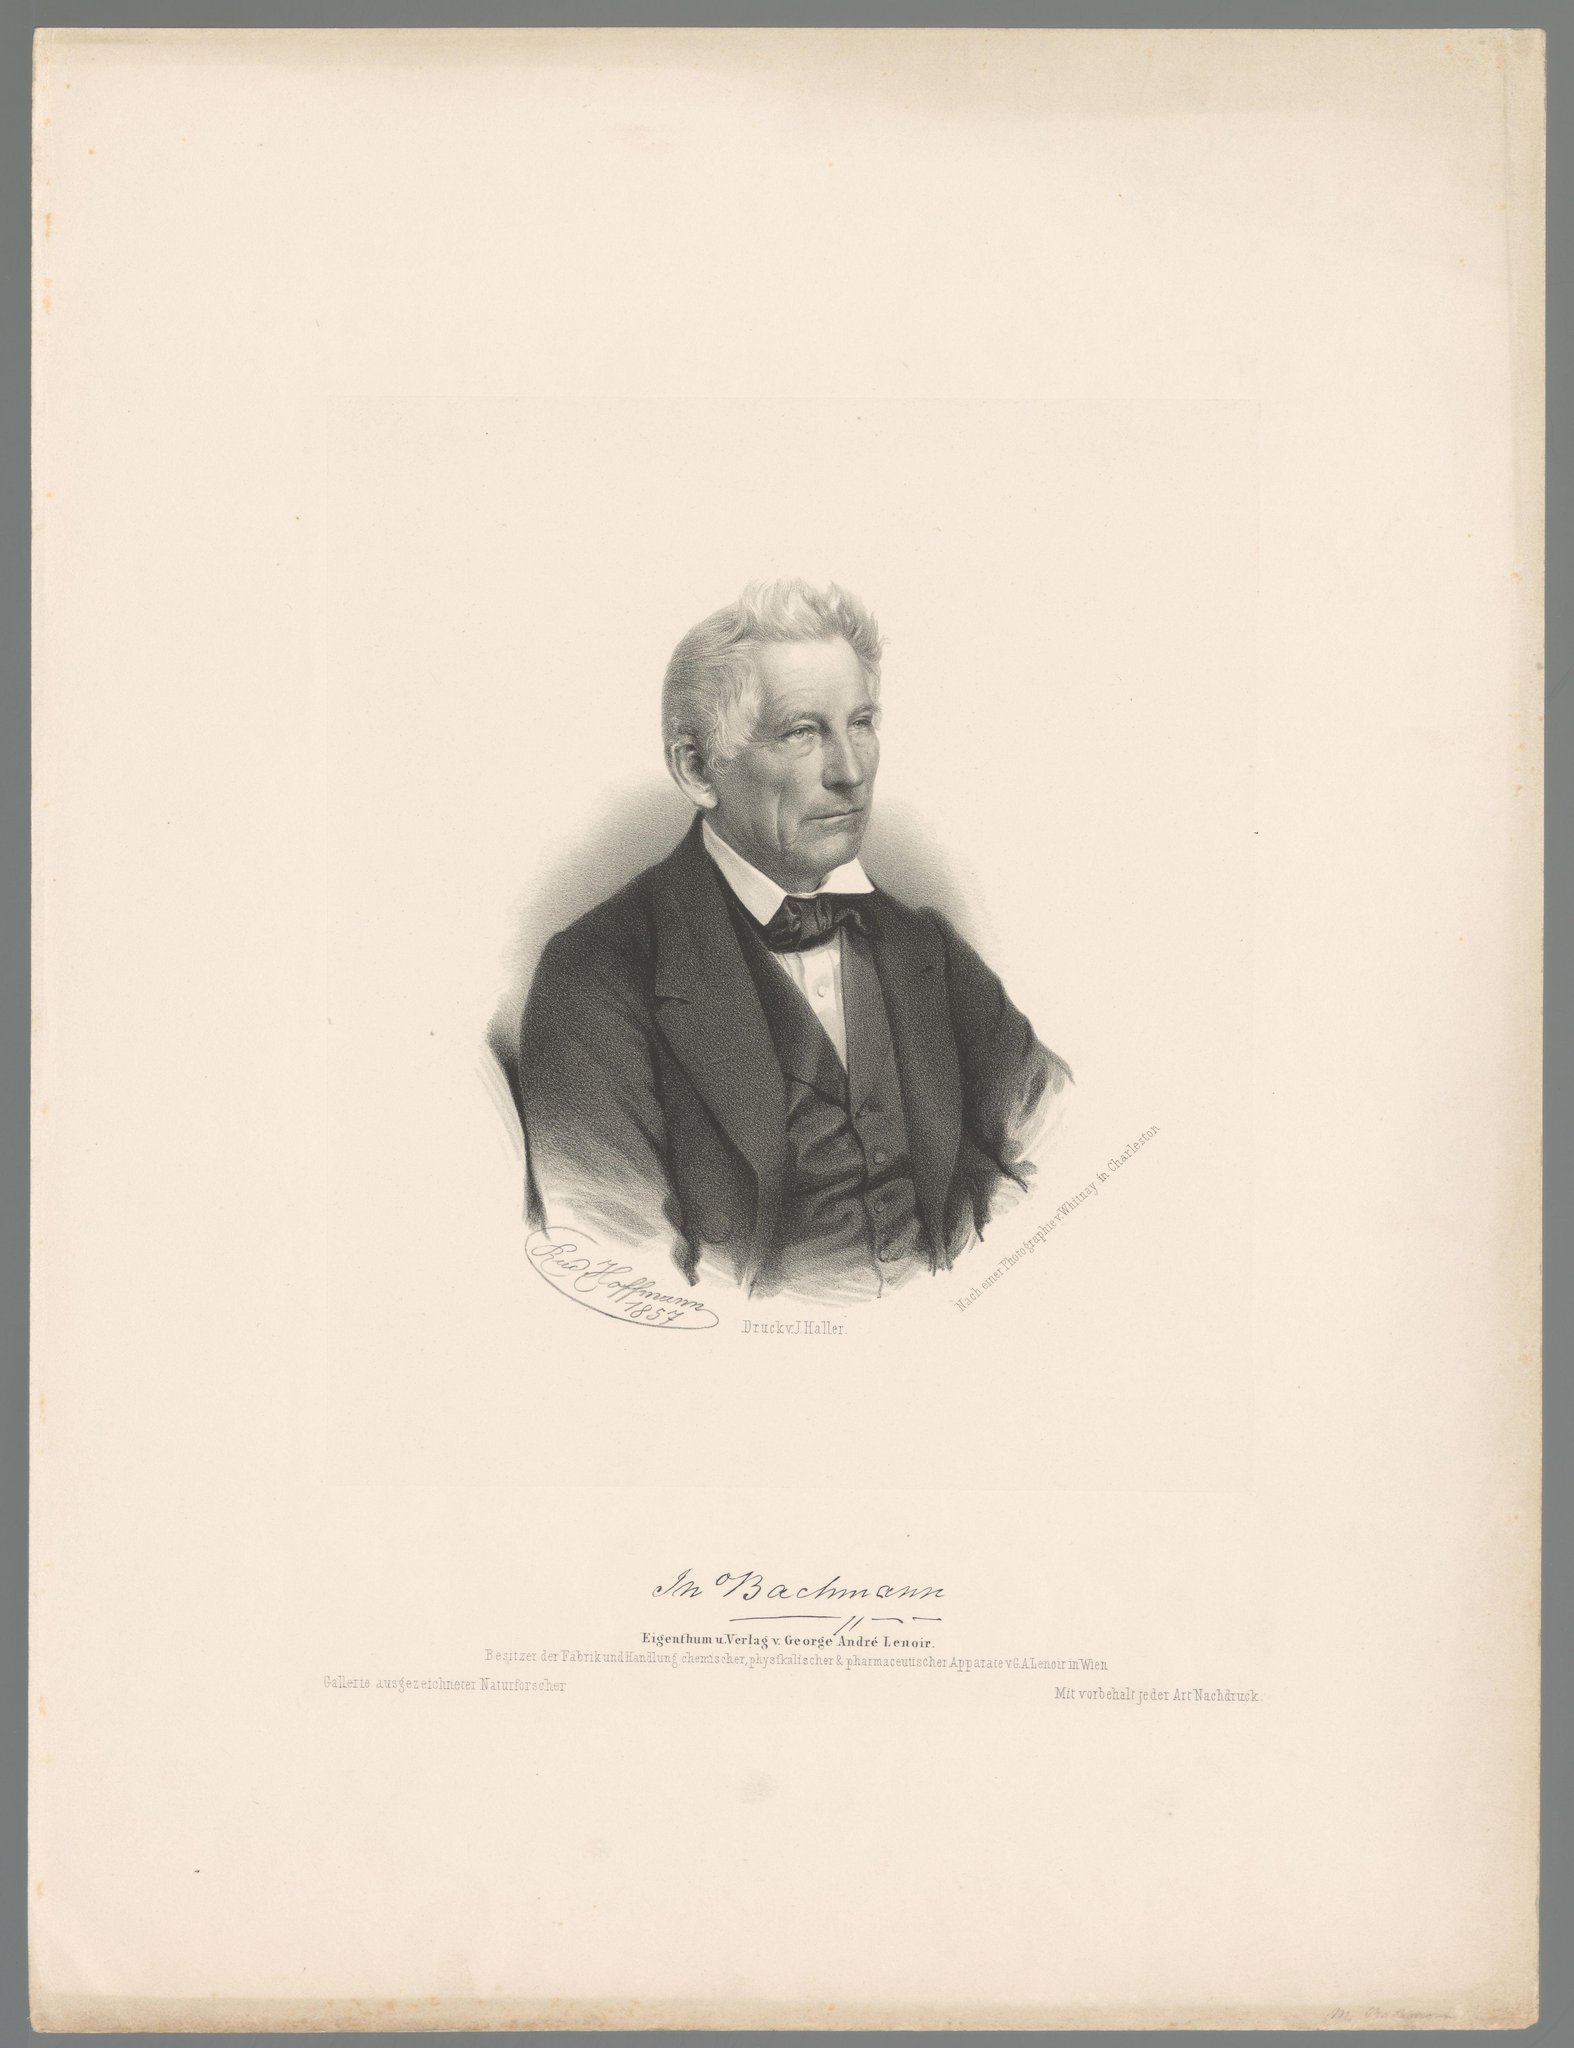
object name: print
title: Gallerie ausgezeichneter Naturforscher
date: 1857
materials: paper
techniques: lithograph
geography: charleston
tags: adult man, historical persons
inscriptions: collector's mark: Lugt 2228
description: Deze prent behoort tot een serie met 100 portretten van natuurwetenschappers, uitgegeven tussen 1856-1860.